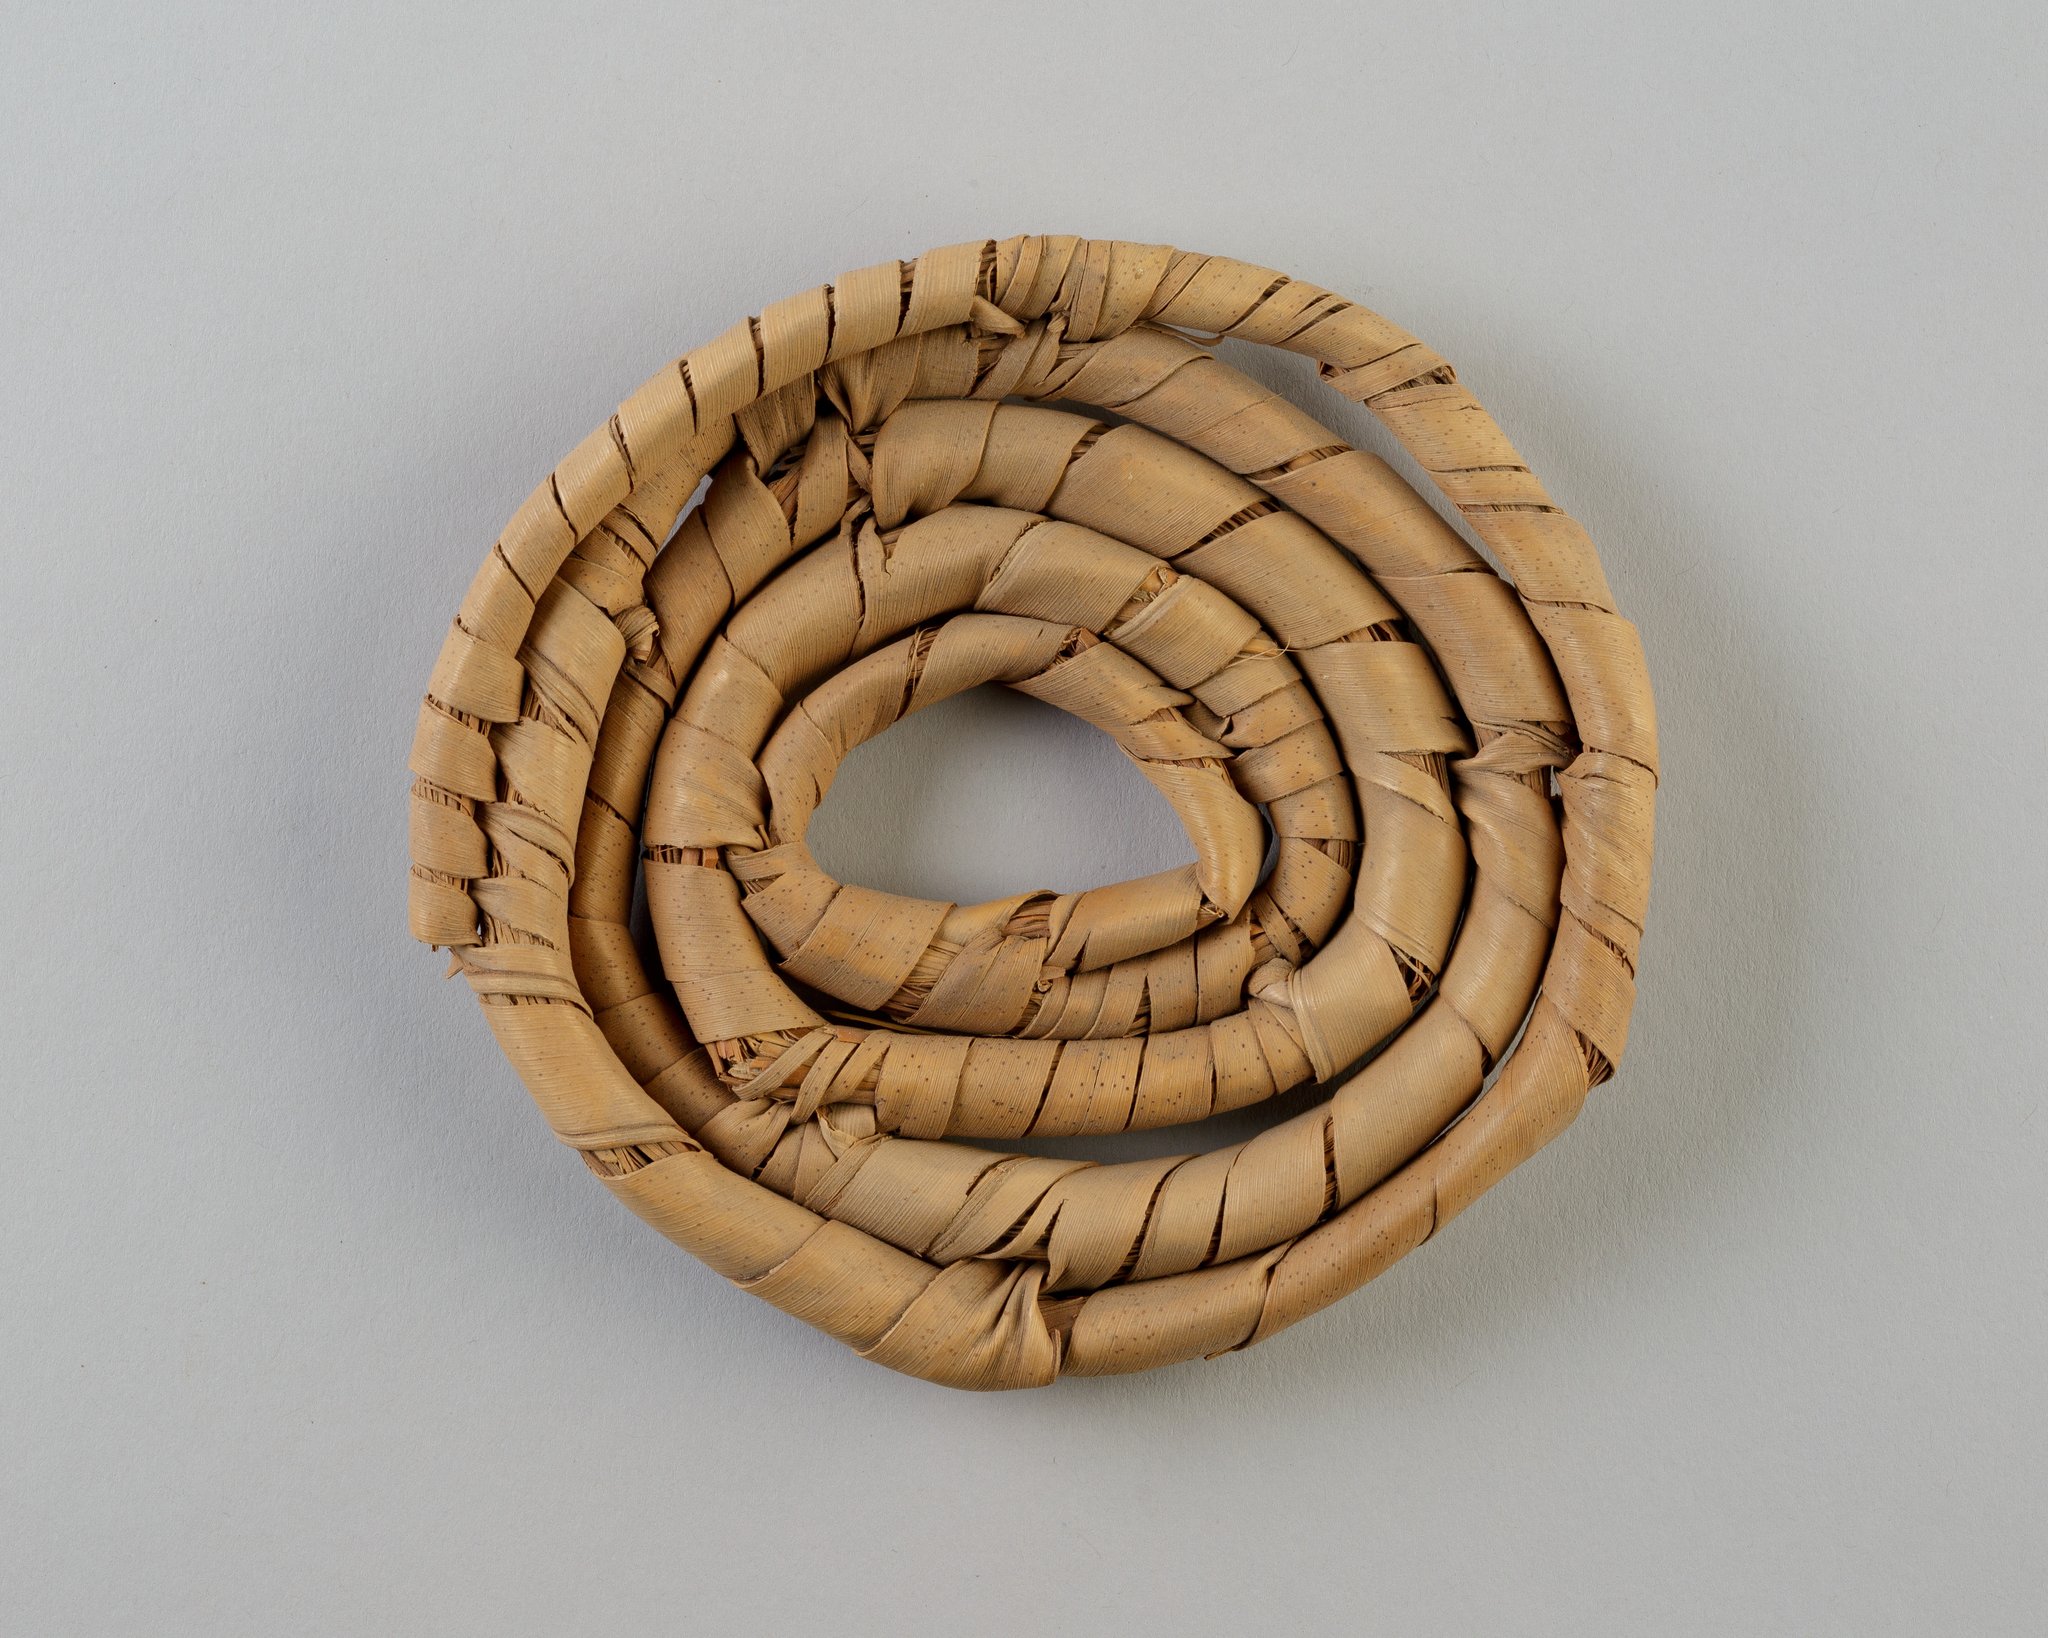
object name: basketry, model, senenmut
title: Pot Stand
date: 1479-1458 BCE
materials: leaf, fiber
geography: egypt